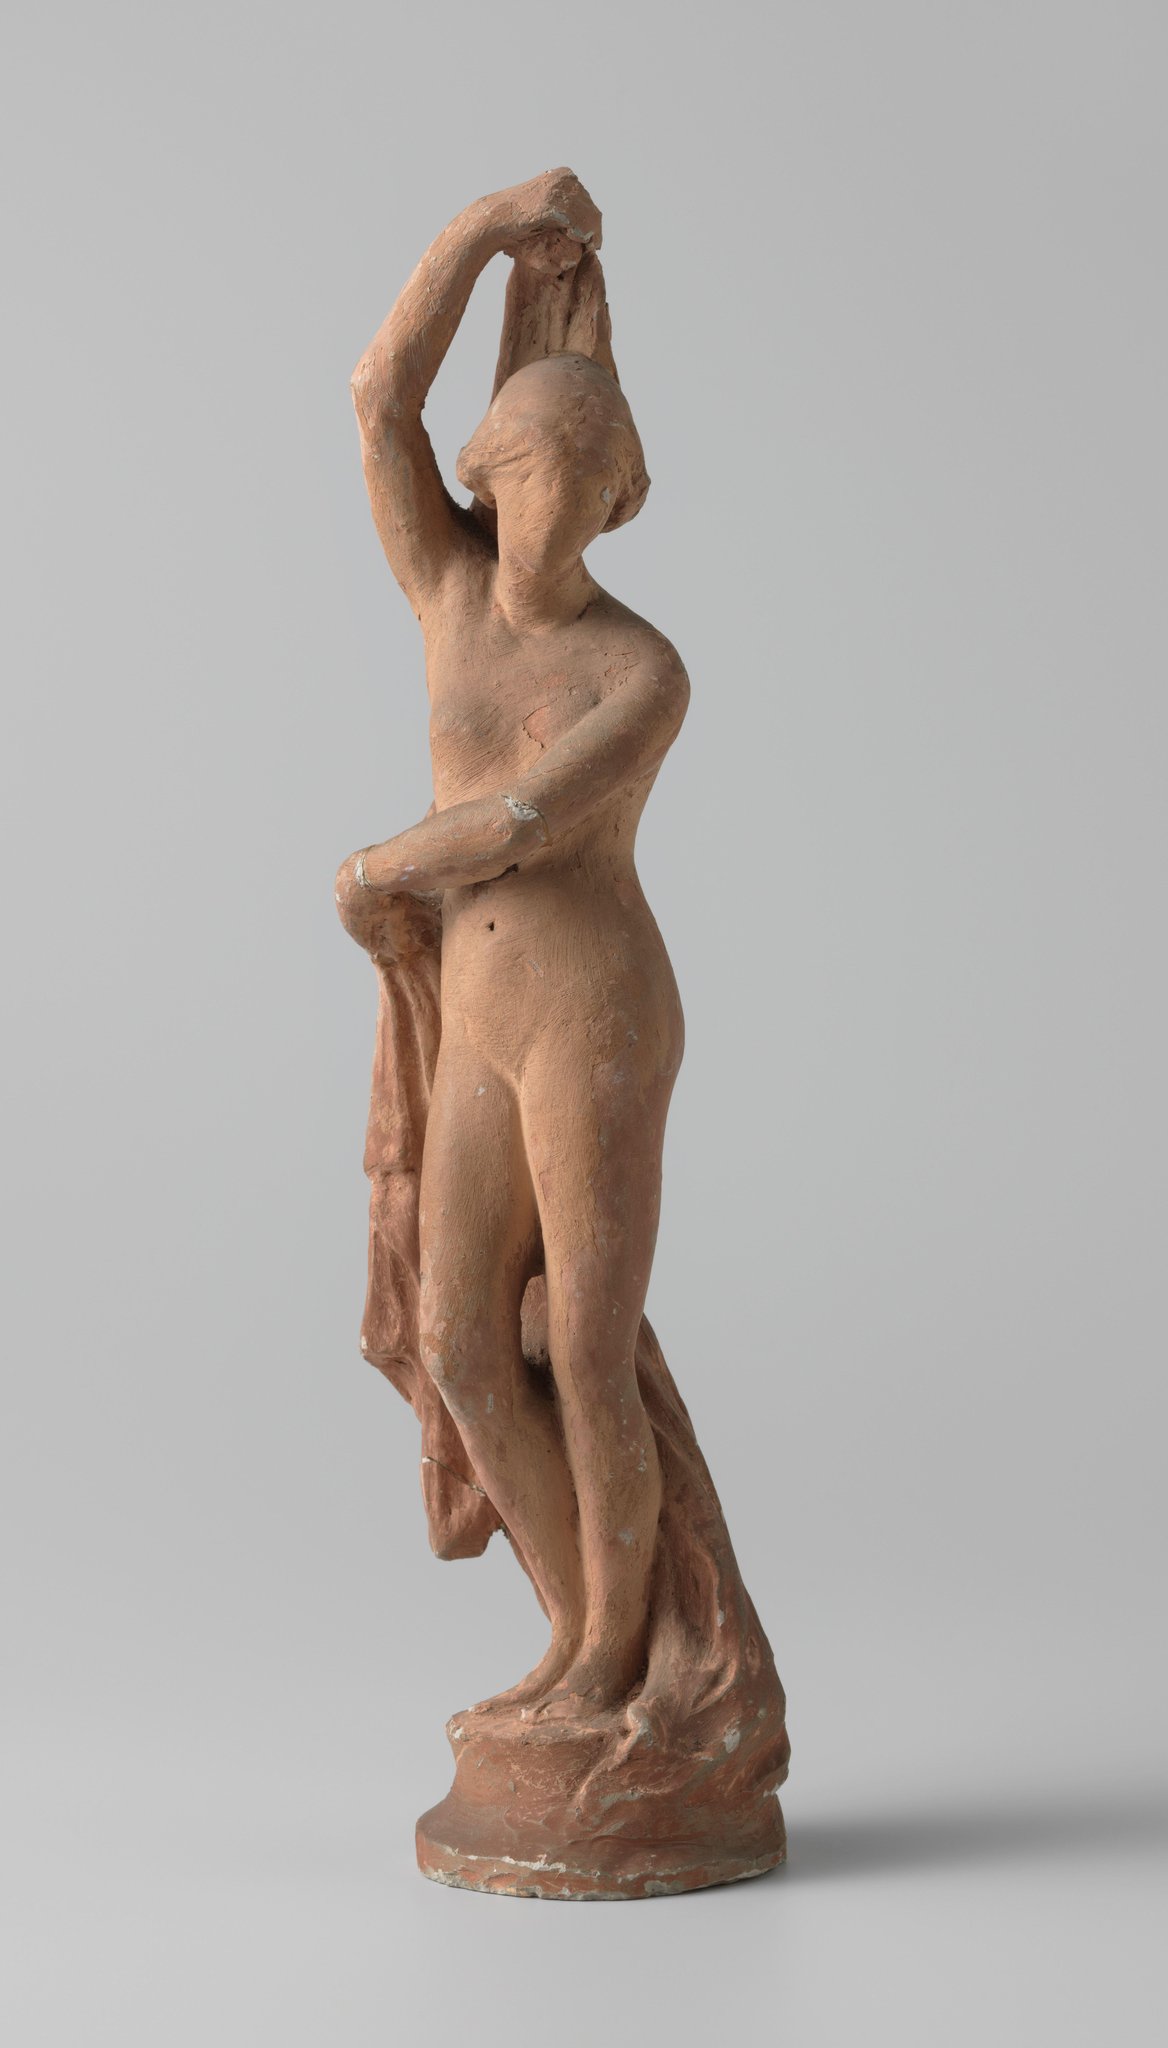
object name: figure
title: Staande figuur van een jonge vrouw in ongebakken klei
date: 1850-1900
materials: clay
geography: netherlands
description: Staande figuur van een jonge vrouw in als terra-cotta gesausde ongebakken klei, zij staat op het linkerbeen, terwijl het rechter in de knie gebogen is; het hoofd, waarvan de trekken zijn uitgewischt is naar links gewend, enigszins omlaag blikkend. Met de rechterhand houdt zij een over haar rug tot op de grond neerhangend doek bij een punt boven haar hoofd, terwijl zij met haar linker voor zich heen het doek, in het midden gegrepen houdt. Zij staat op een hol geprofileerd, rond voetstuk.